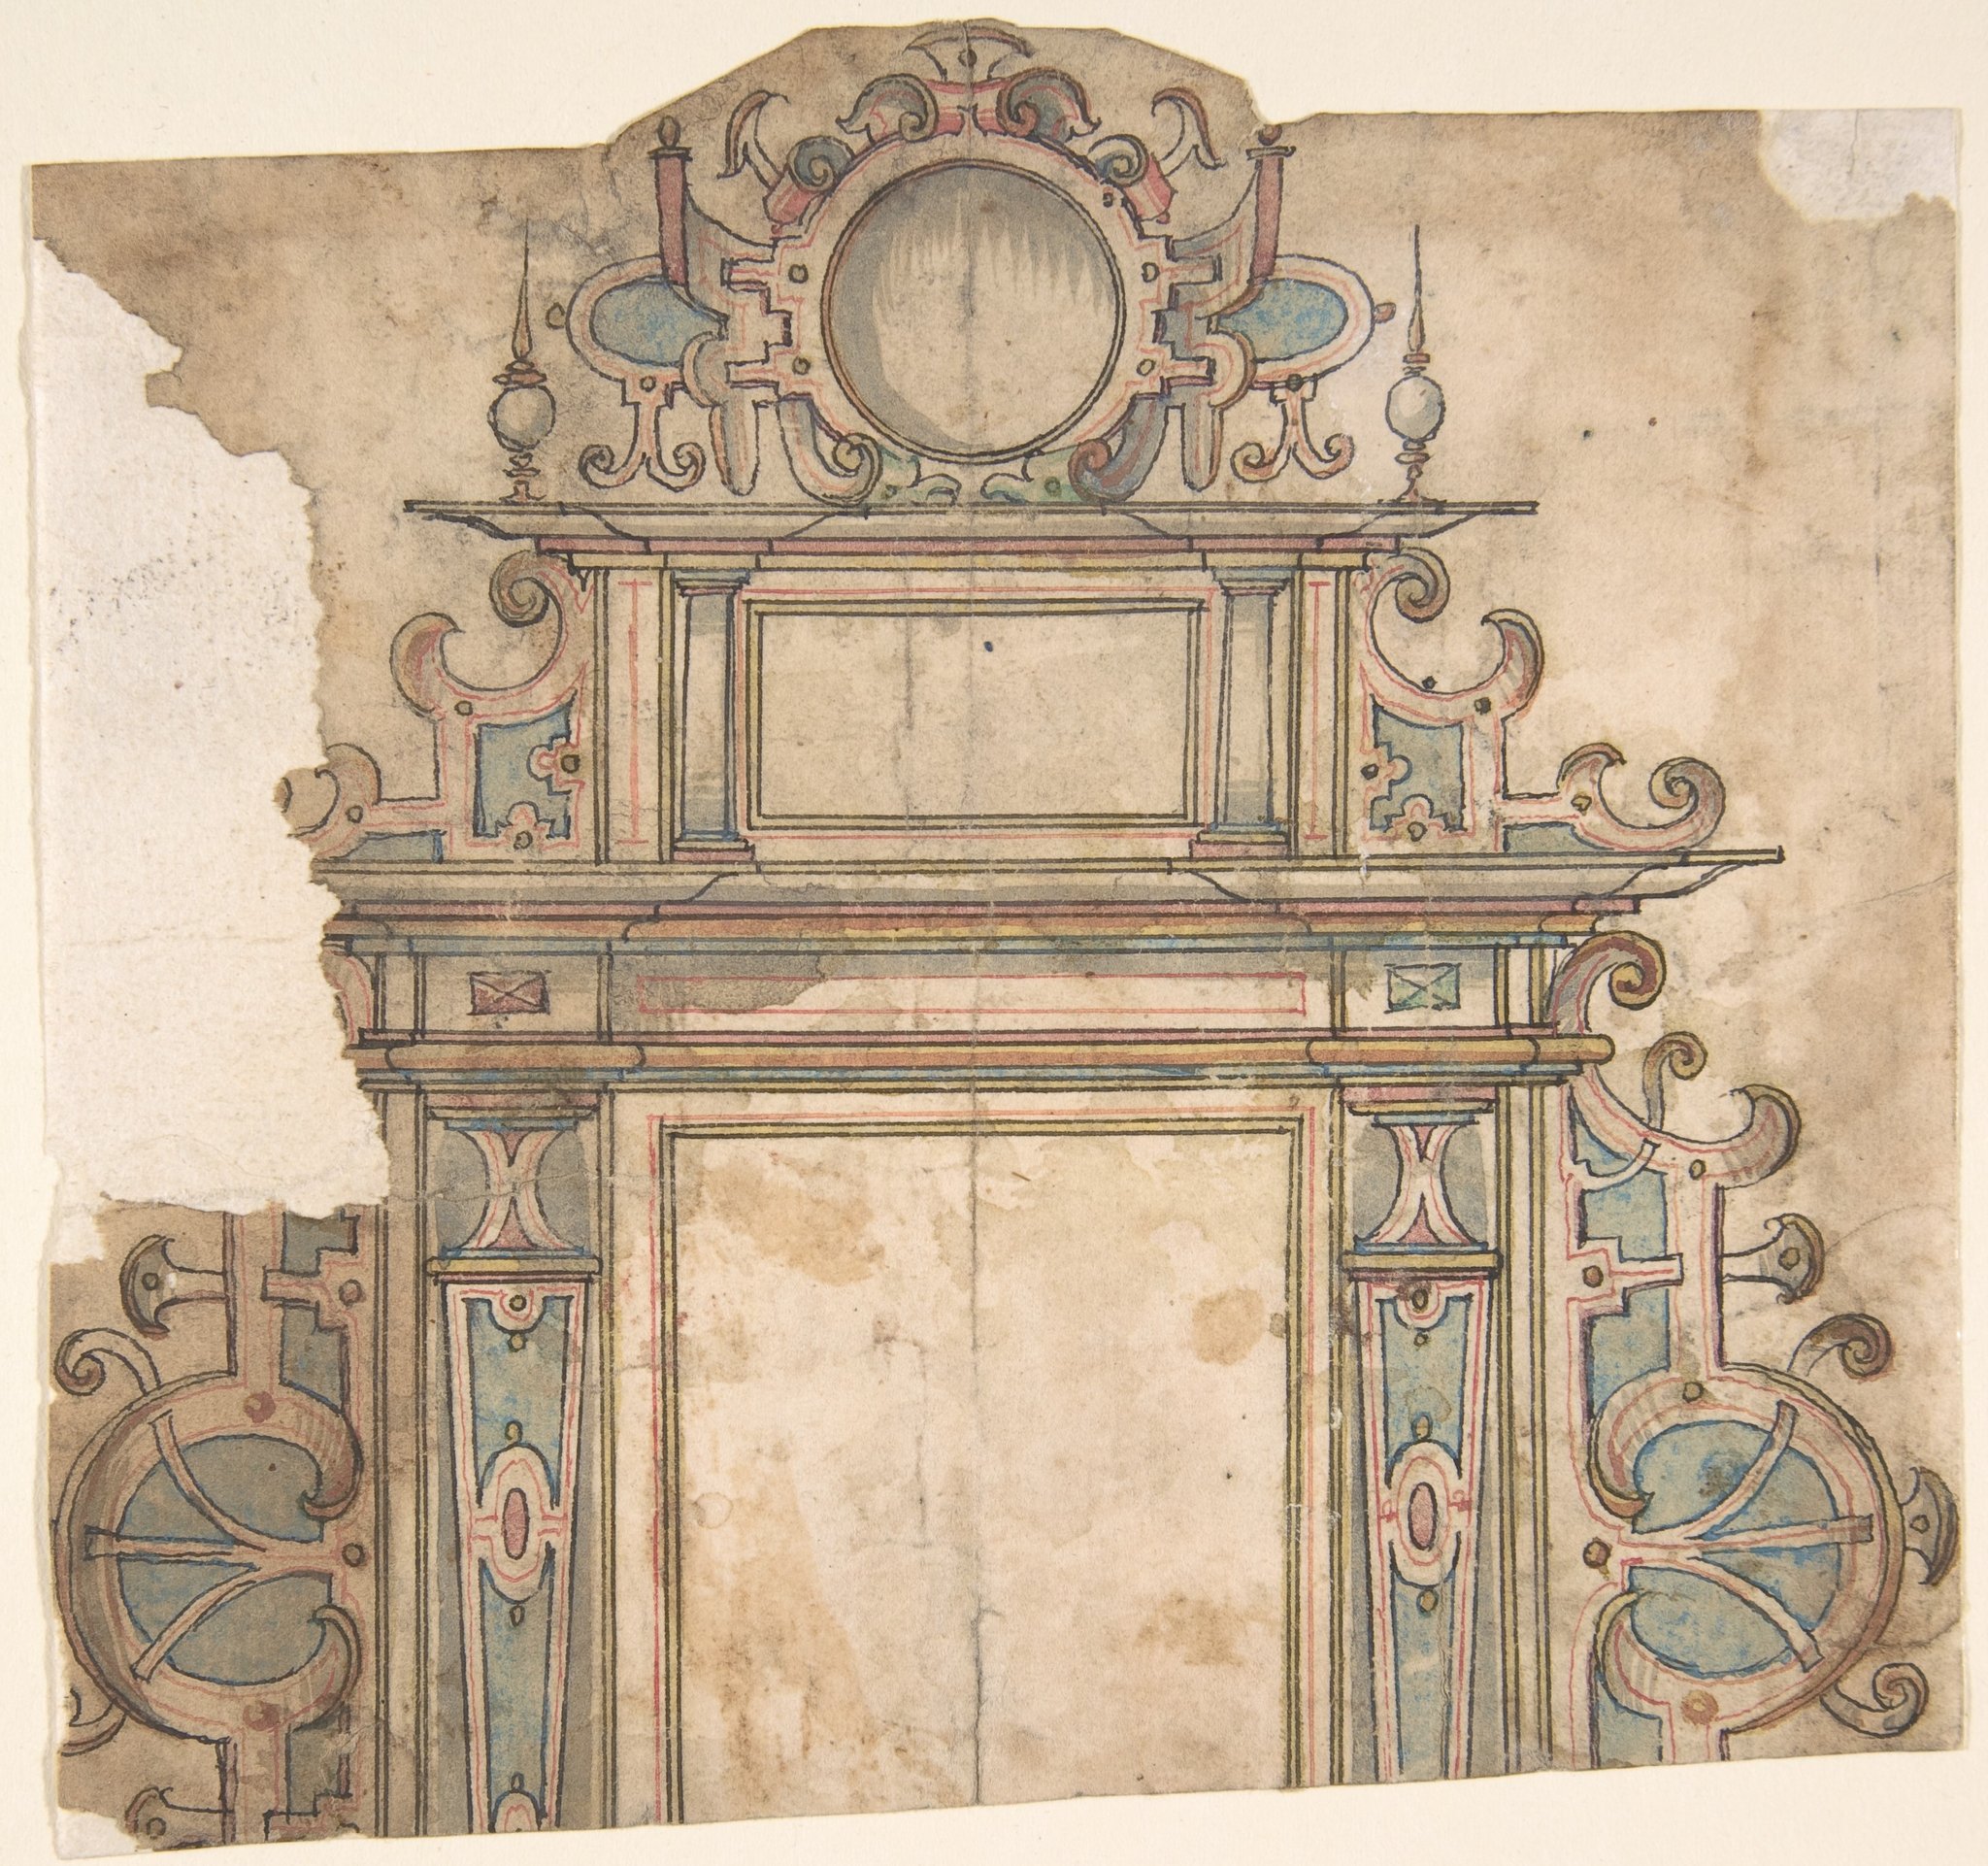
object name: drawing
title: Fragment of design for architectural frame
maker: anonymous, netherlandish, 16th century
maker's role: artist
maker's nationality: netherlandish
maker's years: 1500-1600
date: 1501-1600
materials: ink, watercolor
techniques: pen